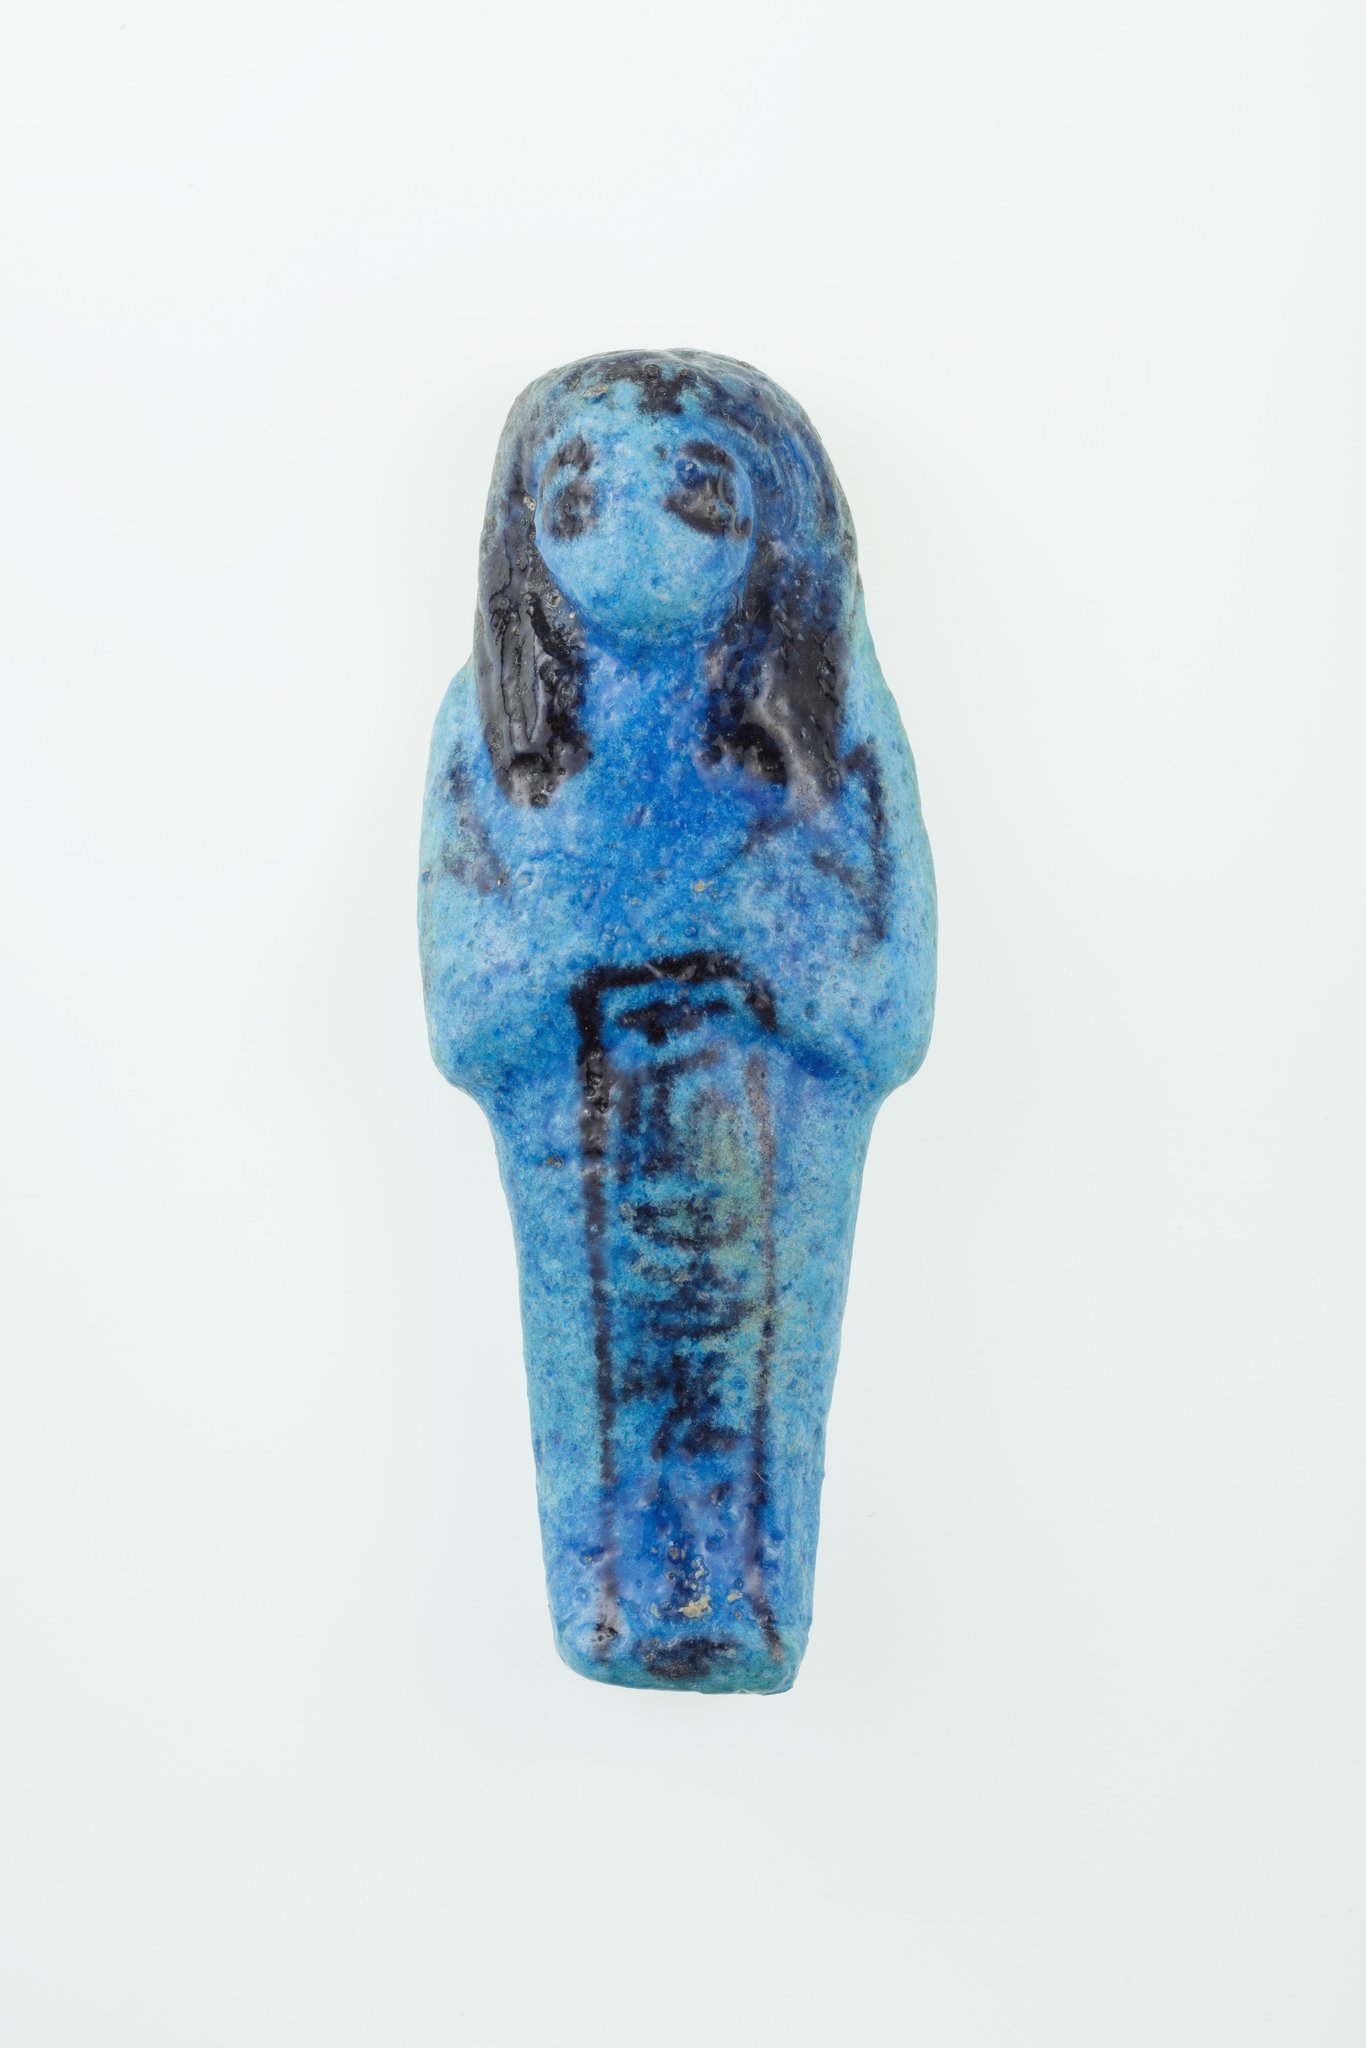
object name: shabti, worker, nauny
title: Worker Shabti of Nauny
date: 1050 BCE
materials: faience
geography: egypt